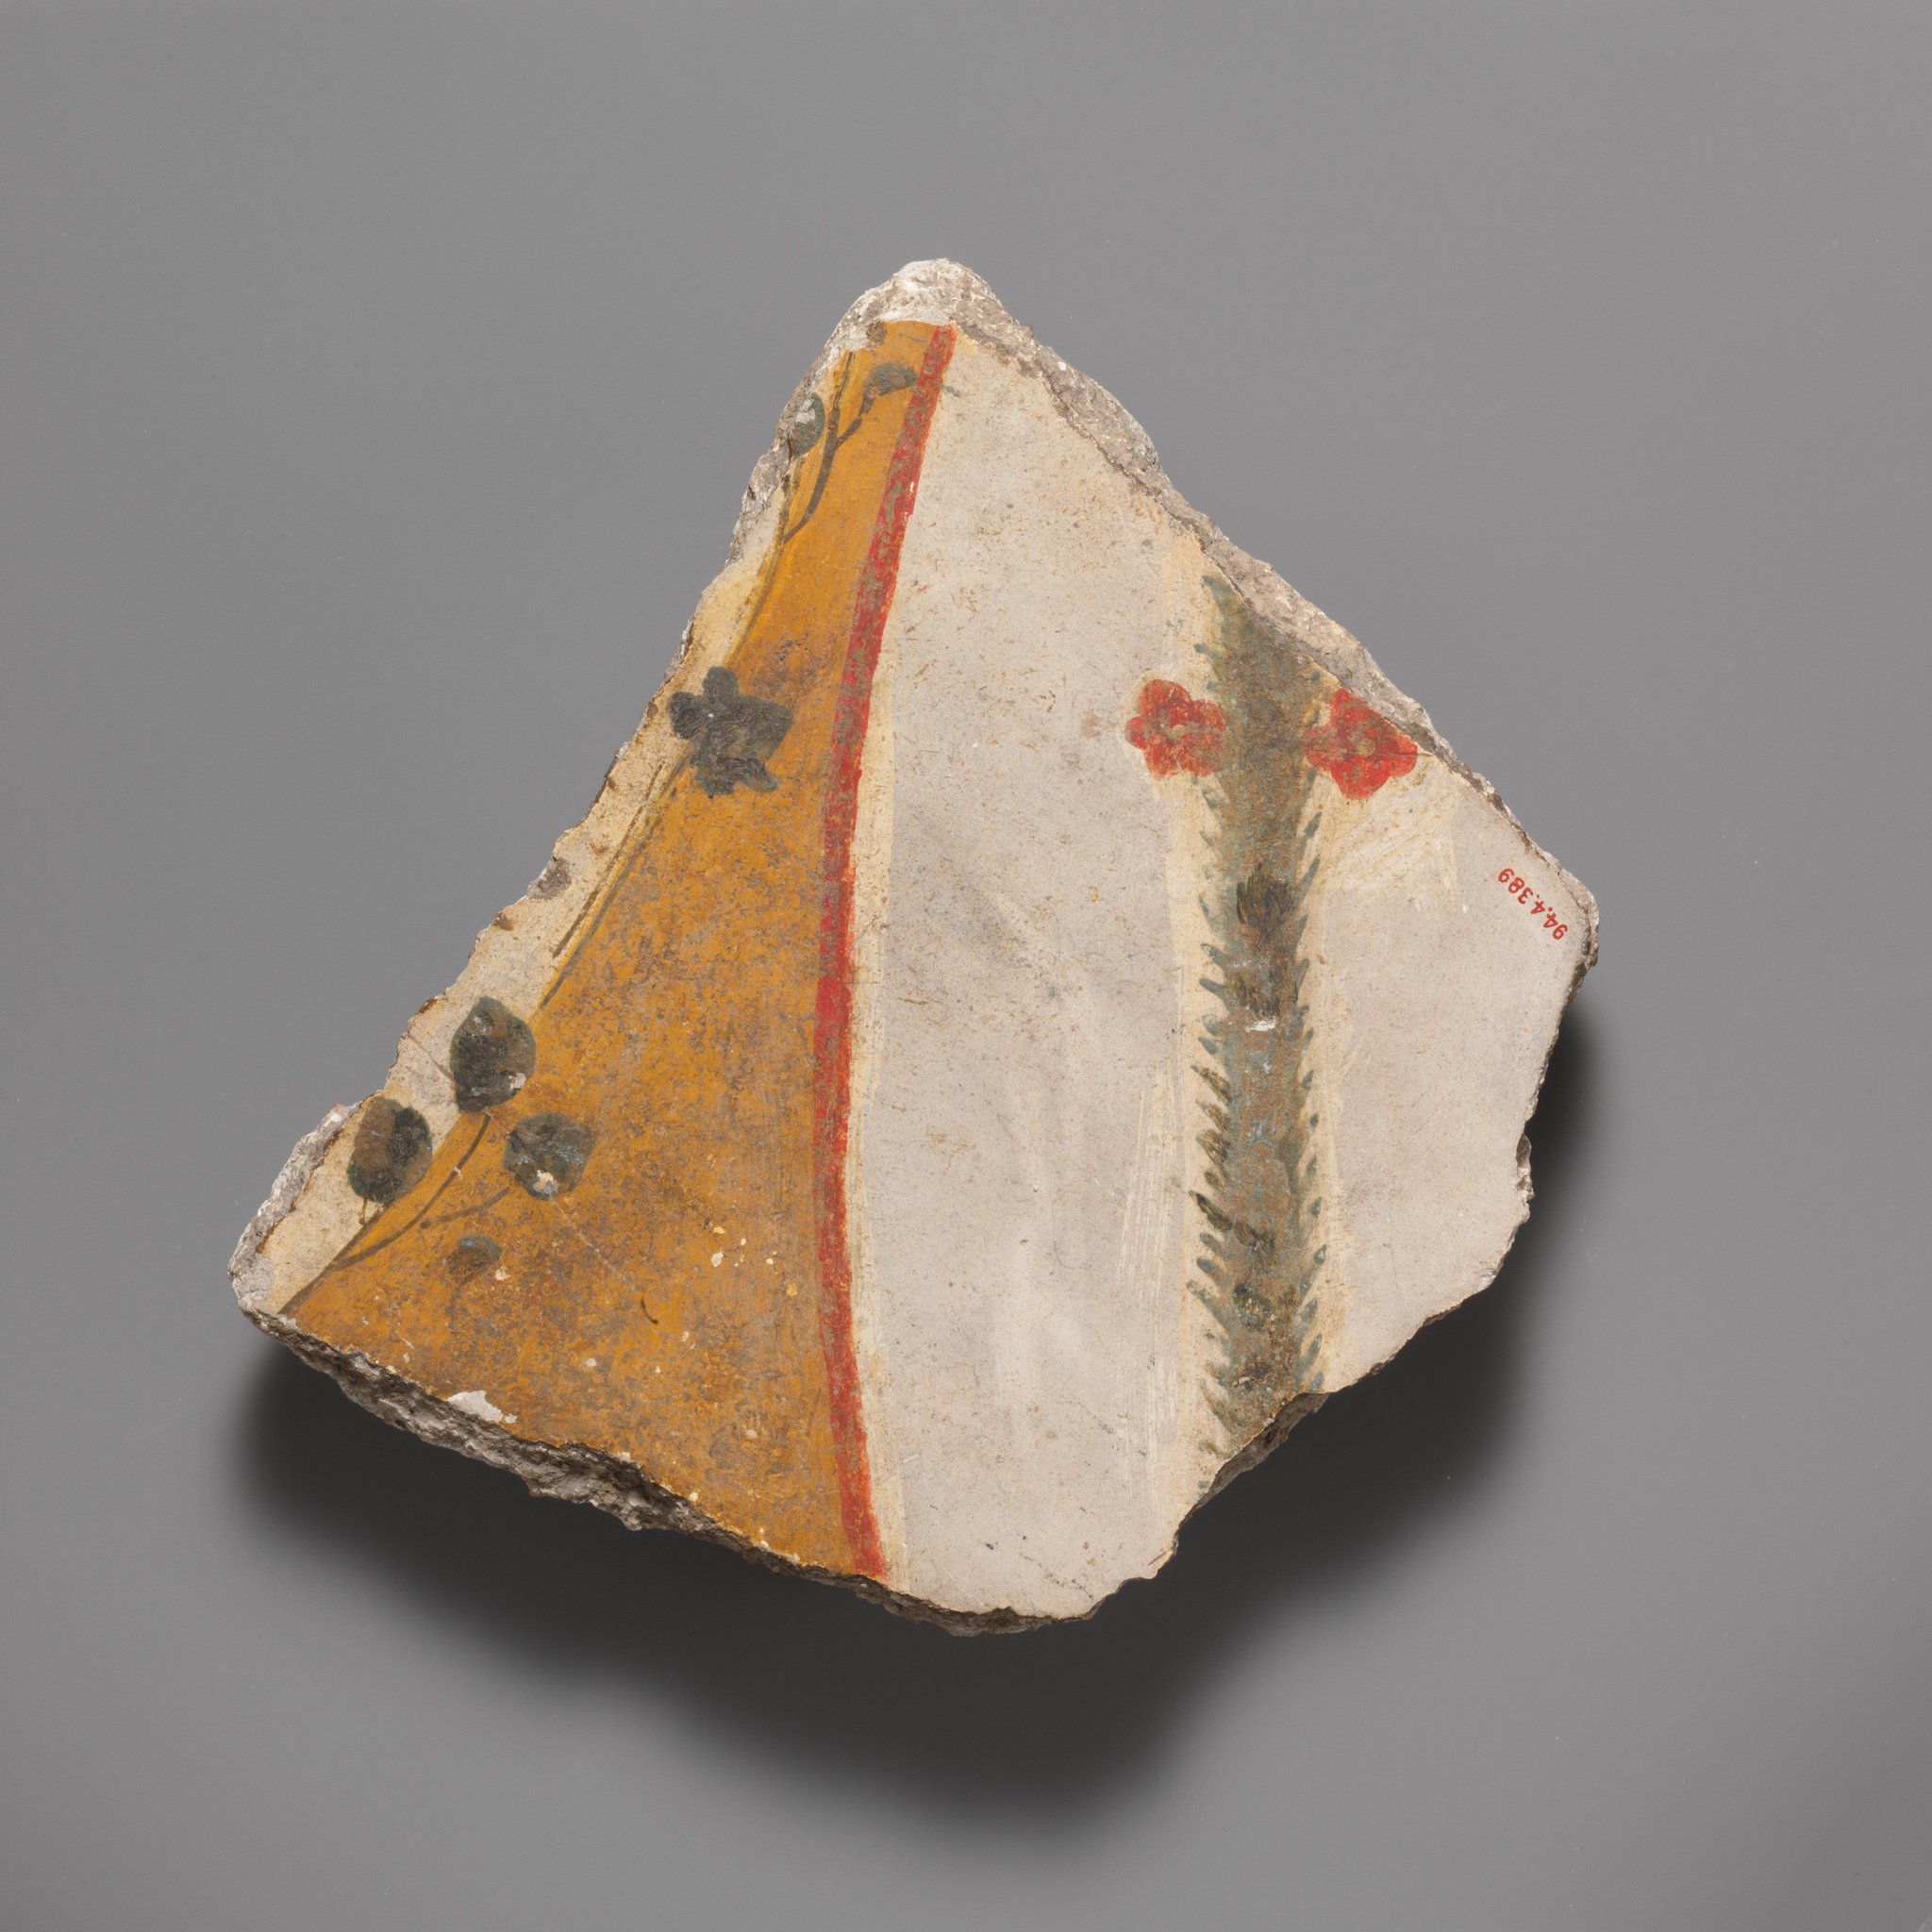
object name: wall painting fragment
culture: roman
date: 1-100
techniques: fresco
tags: flowers,leaves